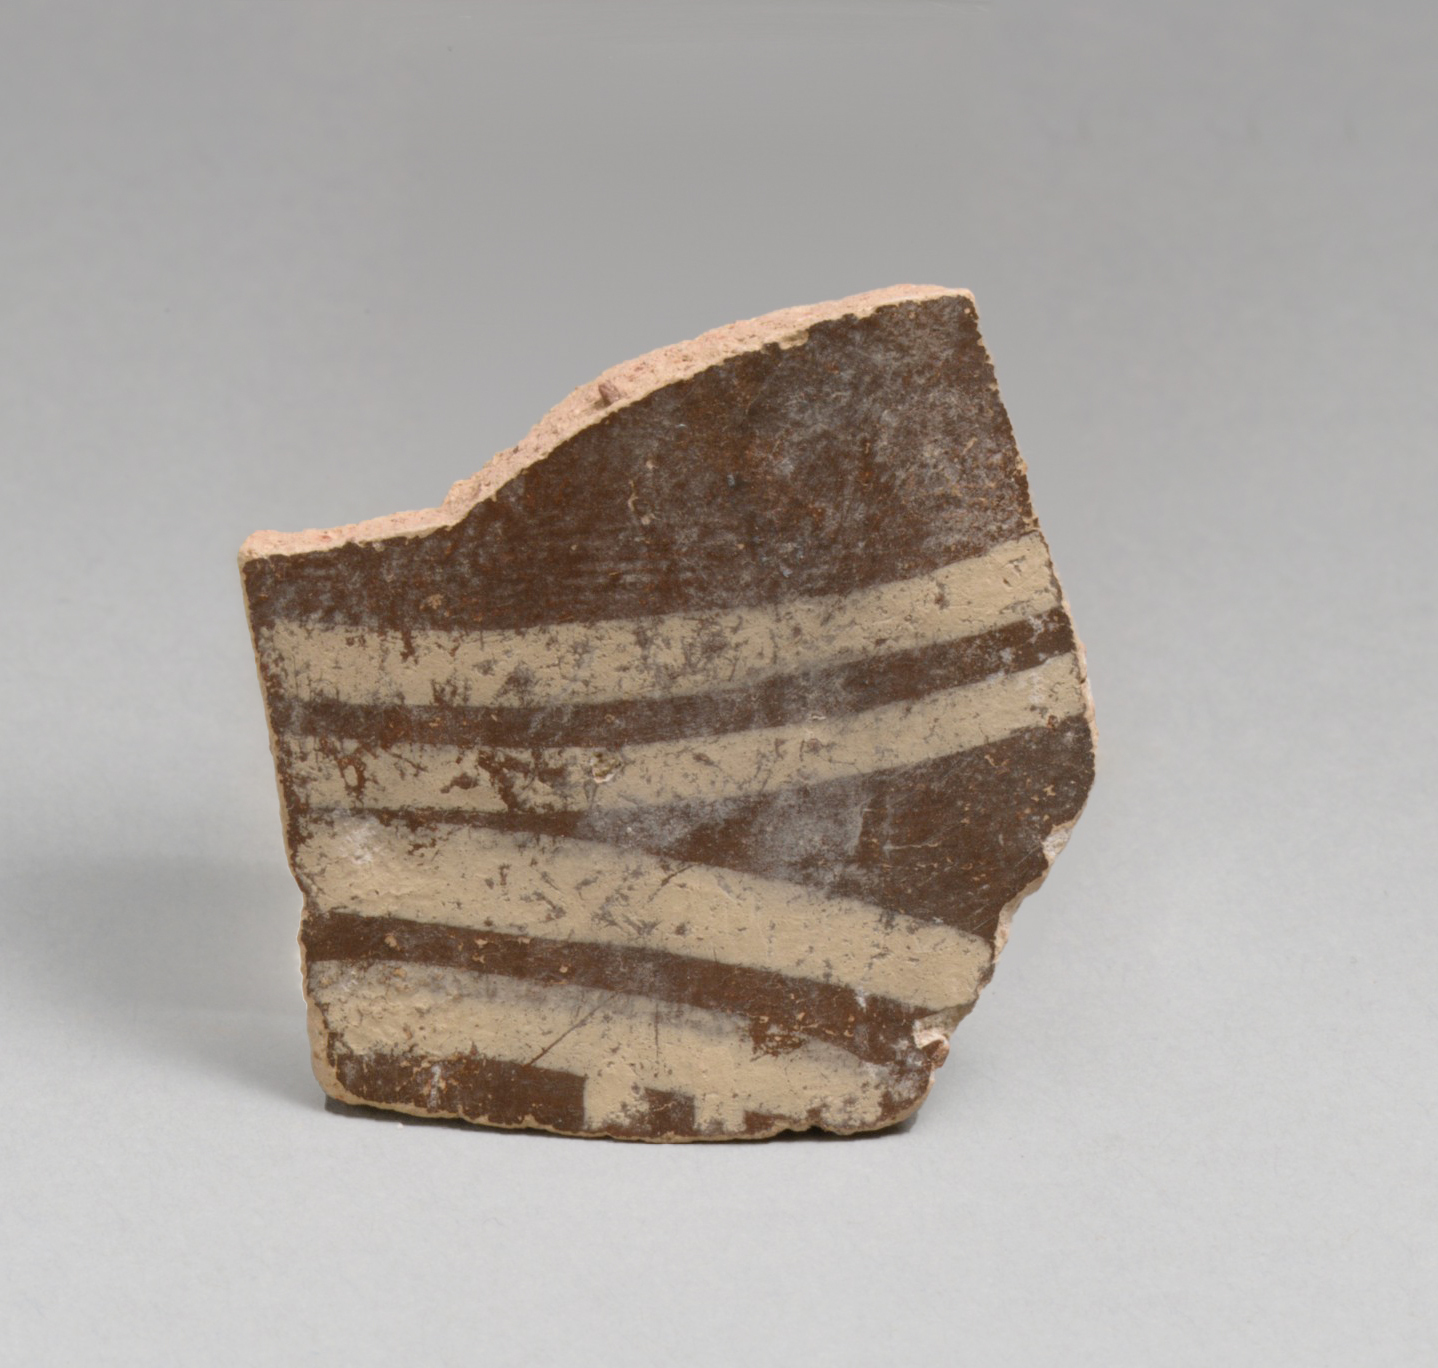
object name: vase fragment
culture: minoan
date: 2600-2000 BCE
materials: terracotta